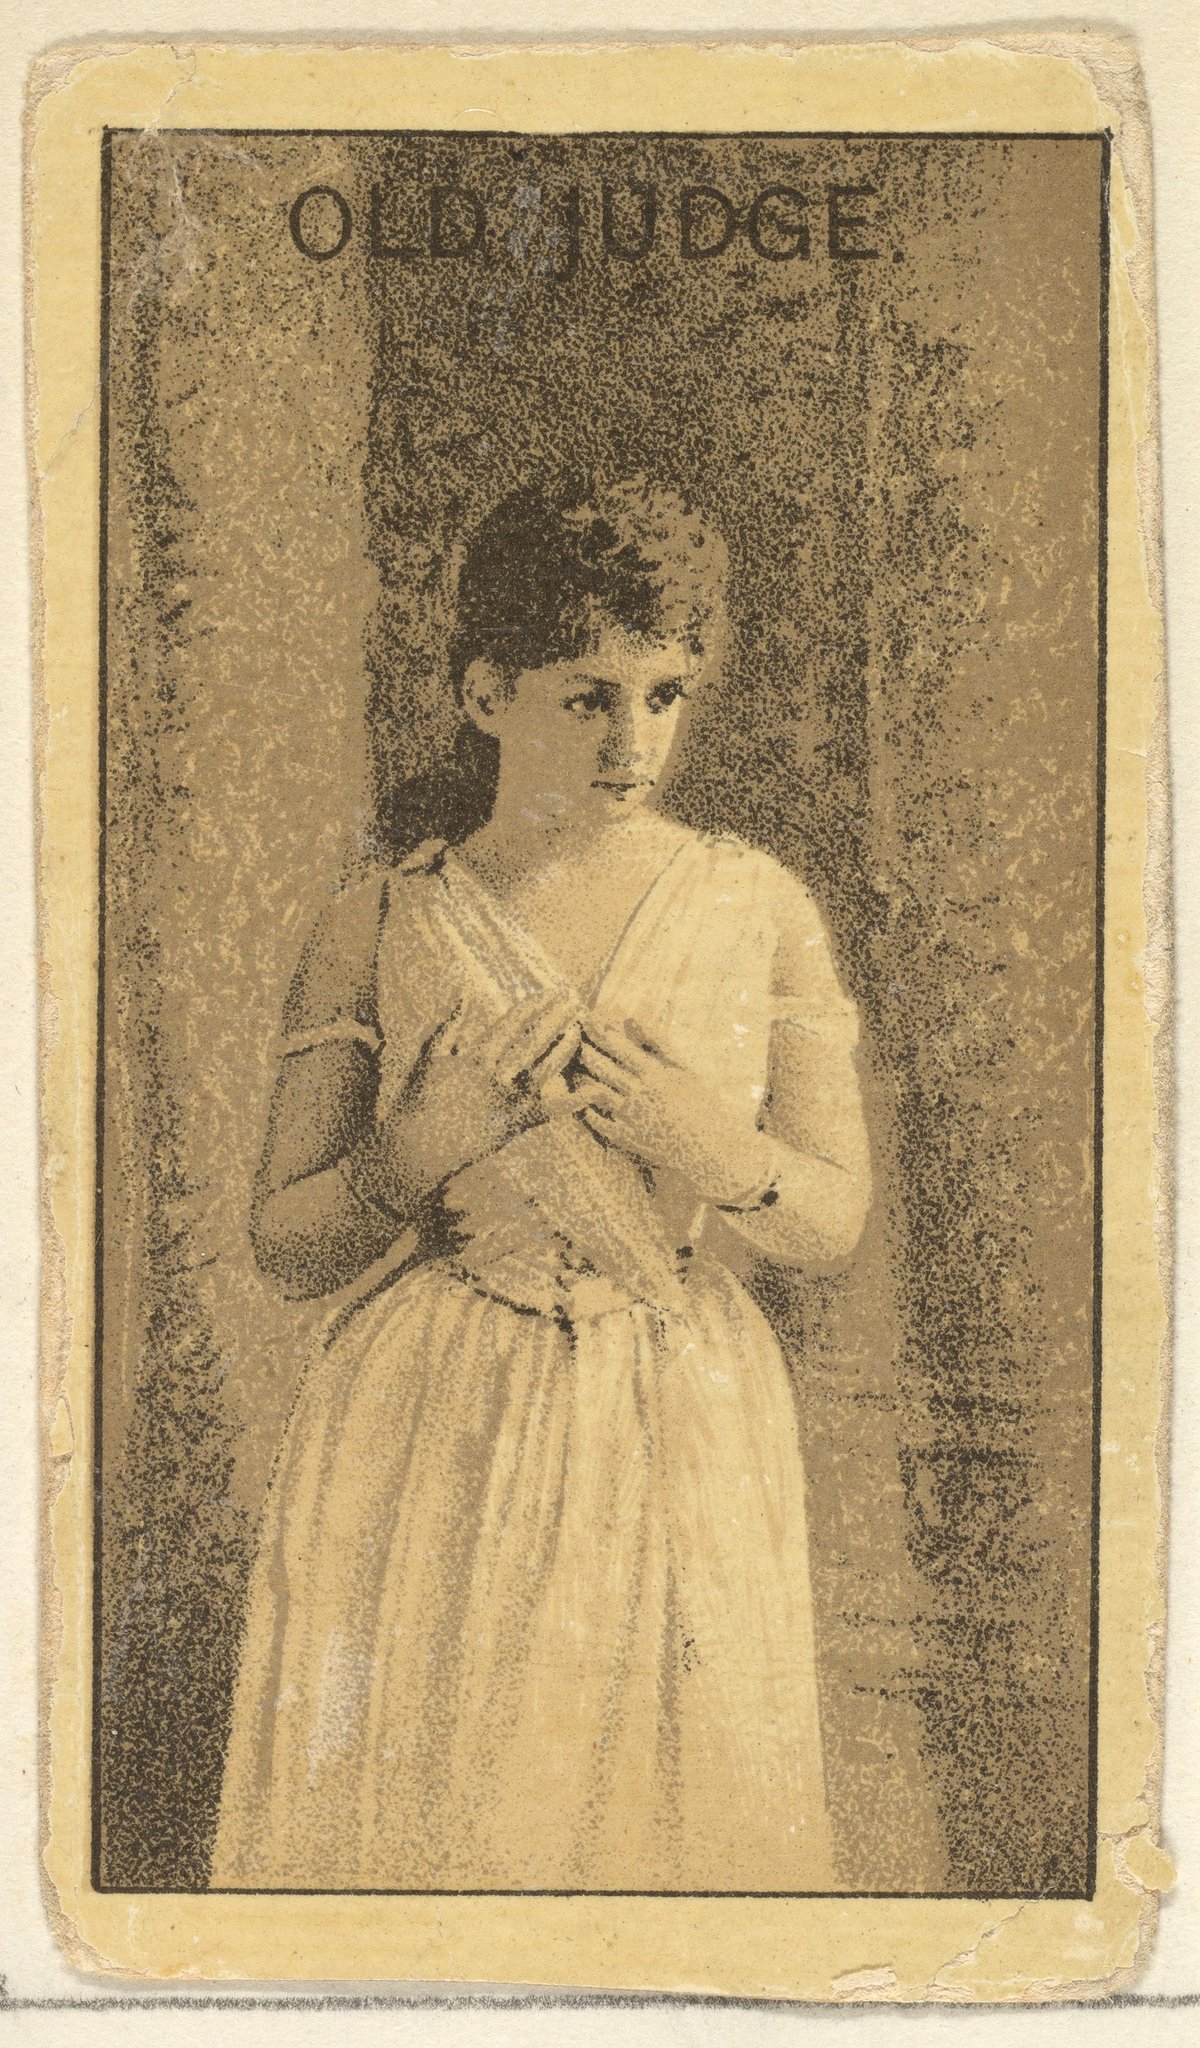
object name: print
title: Actress from the Old Judge series (N167) for Old Judge Cigarettes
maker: goodwin & company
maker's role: publisher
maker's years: 1850-1950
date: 1886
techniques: lithography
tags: portraits,women